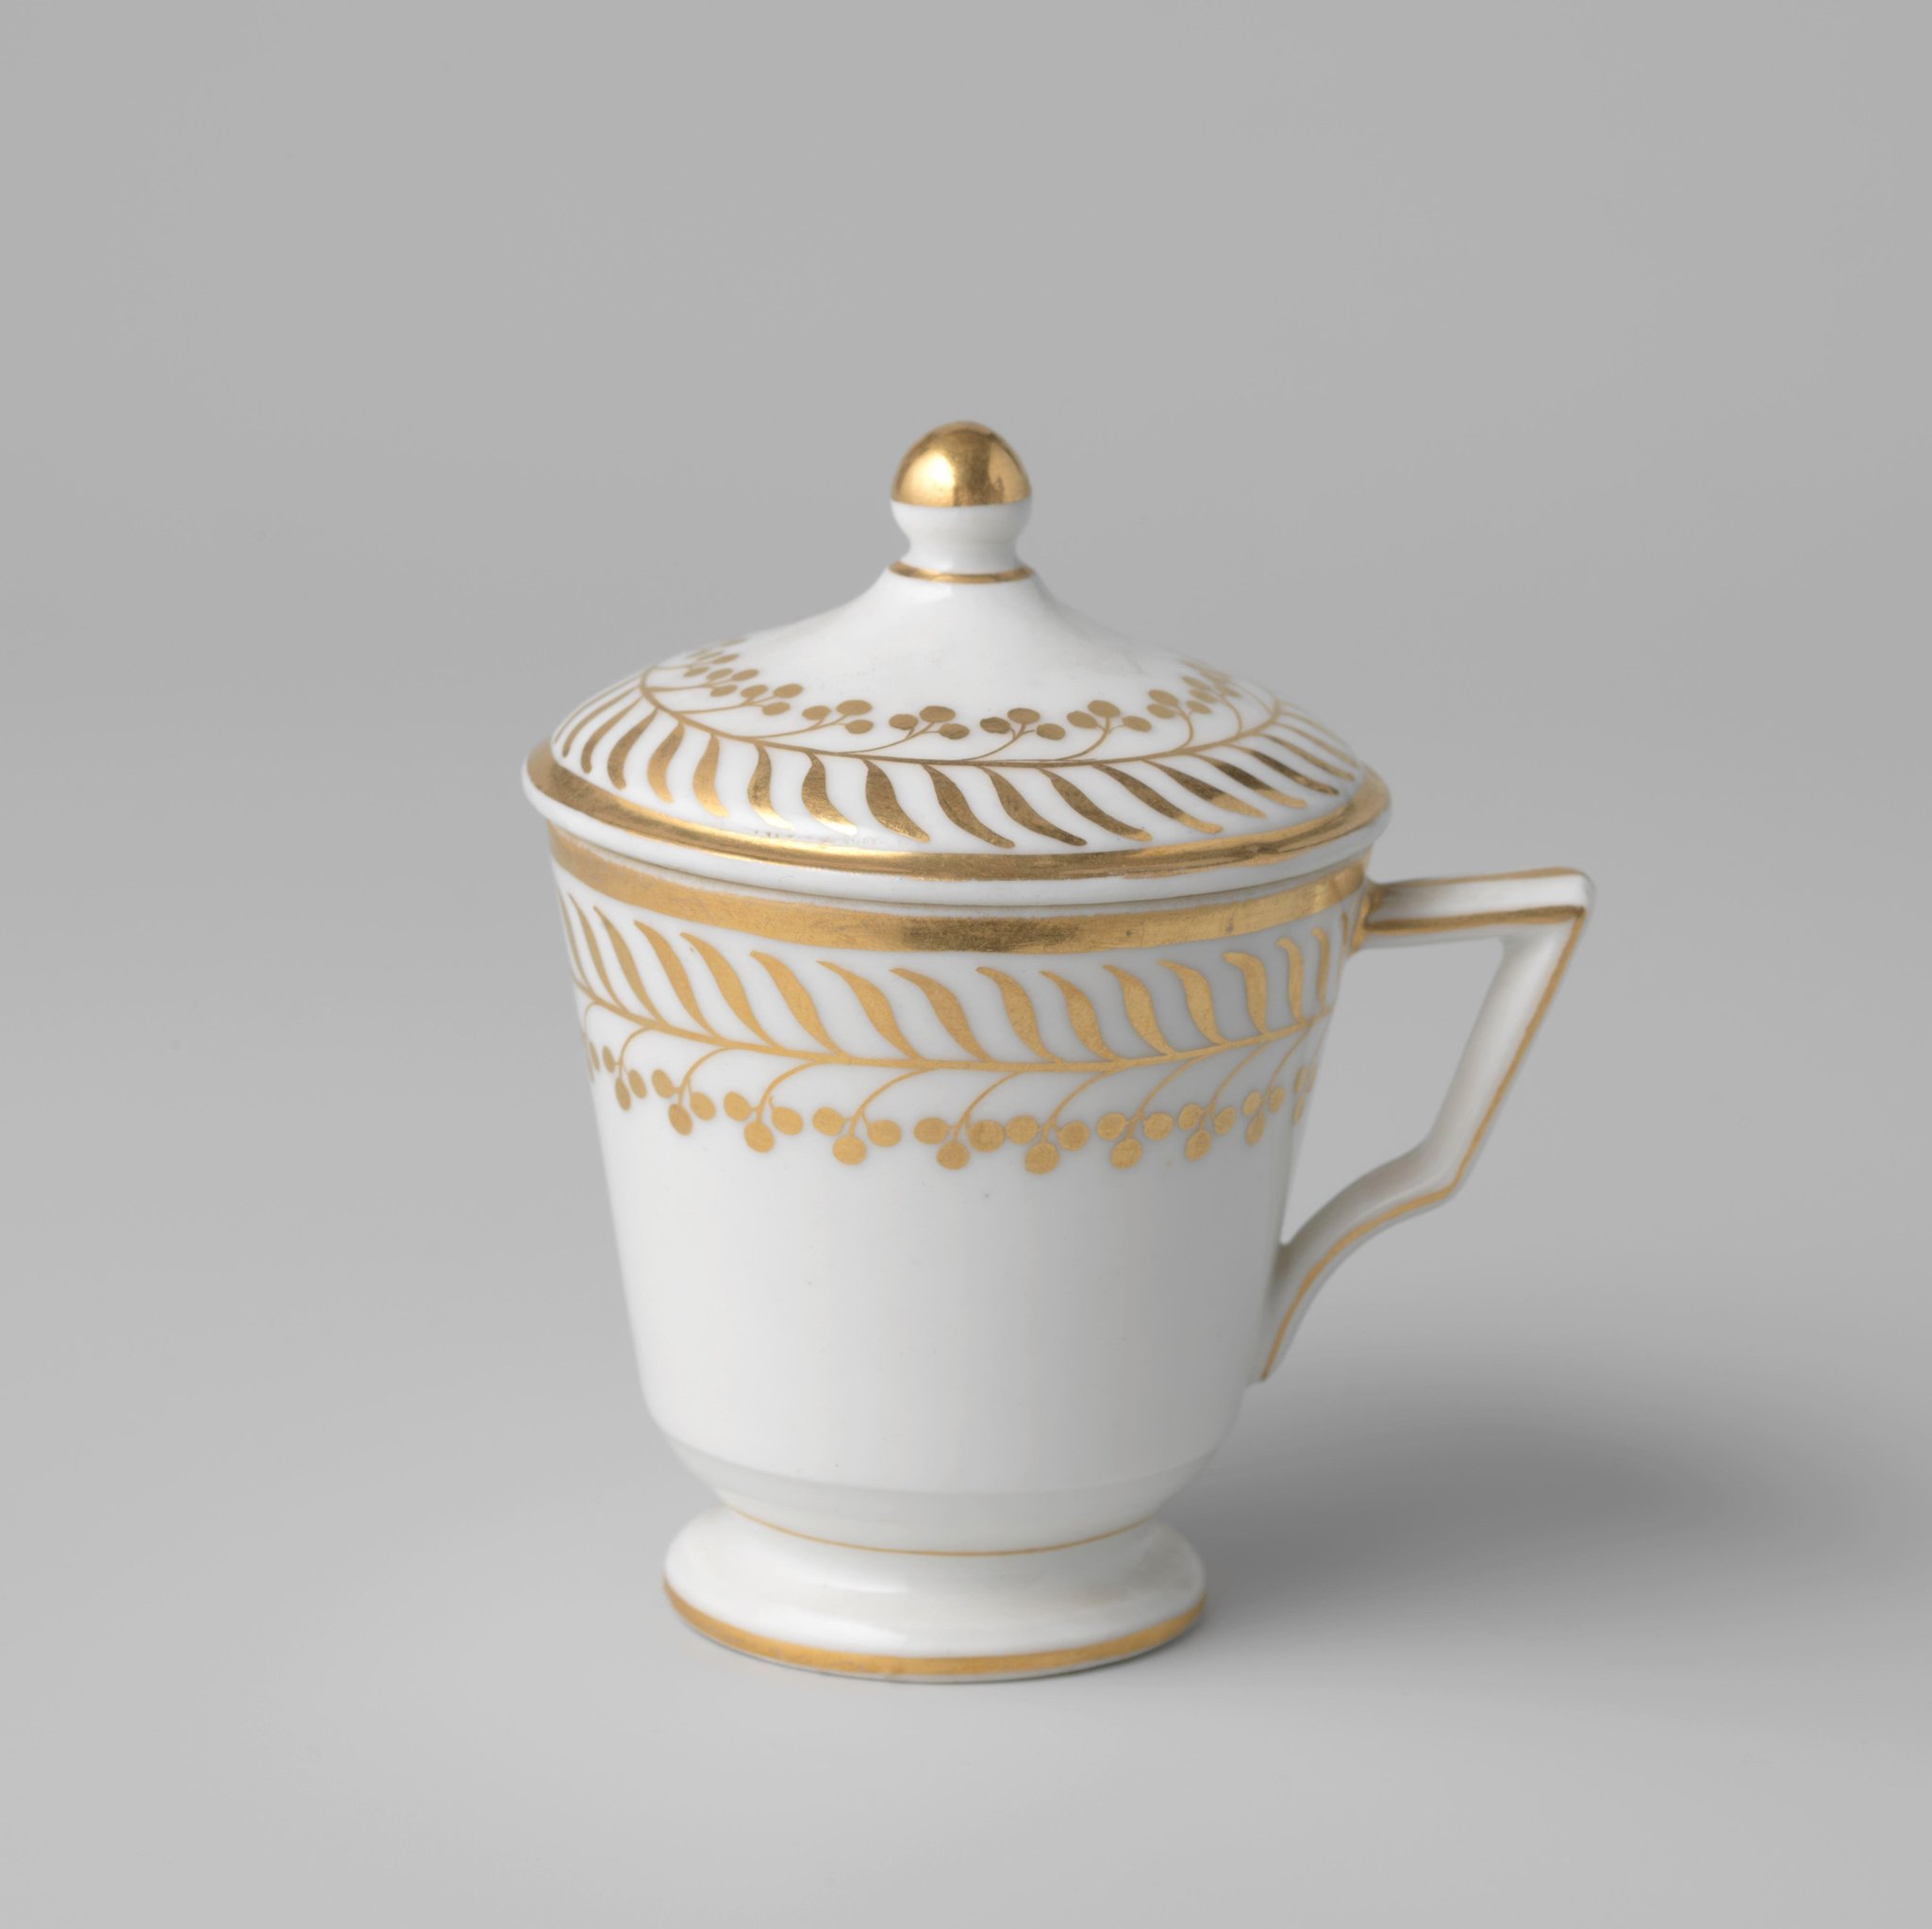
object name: crèmepot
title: Covered cup (pot de crème) with stylized floral scrolls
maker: Anonymous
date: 1800-1810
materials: glaze, gold, paint, porcelain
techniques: firing, forming, gilding, vitrification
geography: france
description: Crêmepot van porselein met oor. Versierd met gouden biezen en langs de randen beschilderd met een doorlopende tak met aan de ene zijde bladeren, aan de andere zijde steeds een tak met drie vruchten. Gemerkt met ingegrifte 1.